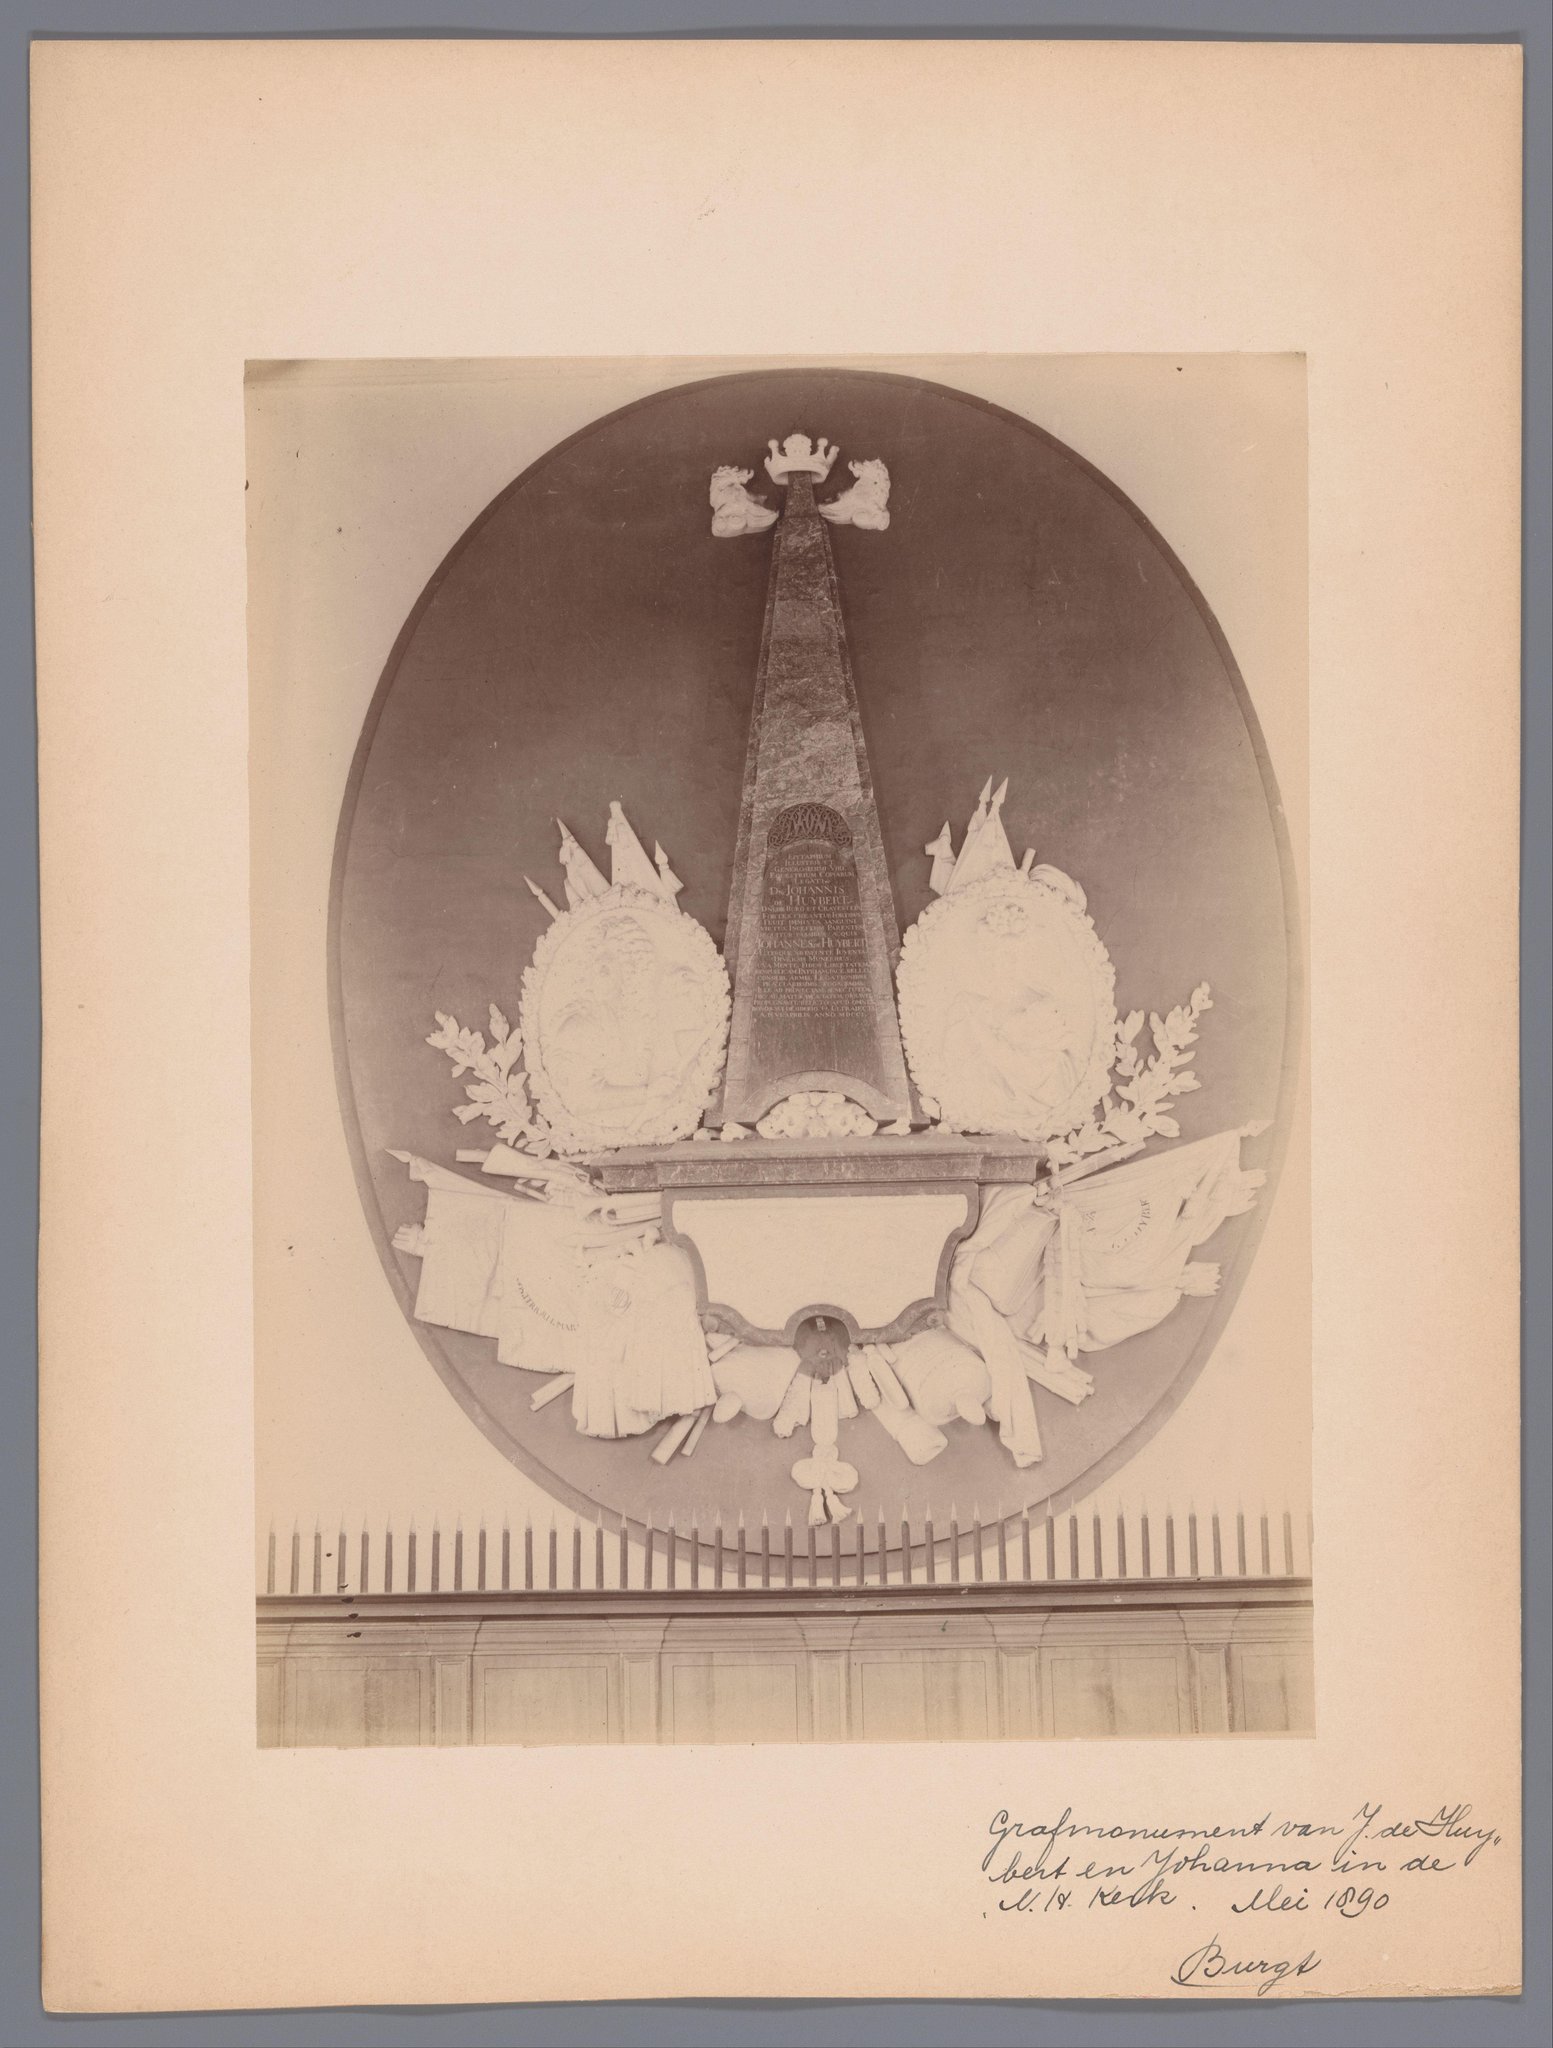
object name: photograph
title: Grafmonument van Justus en Johanna de Huybert in de Hervormde Kerk te Burgh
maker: anoniem (monumentenzorg)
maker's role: fotograaf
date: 1890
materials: cardboard, photographic support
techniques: albumen print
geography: burgh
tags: justus de huybert, grave-building, monumental tomb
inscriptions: annotation: ‘Grafmonument van J. de Huybert en Johanna in de N.H. Kerk. Mei 1890/ Burgh’, annotation: ‘Monument in de Kerk v/d N.H. gemeente te Burgh (schouwen) Zeeland/ (Noodmuur). Mei 1890’